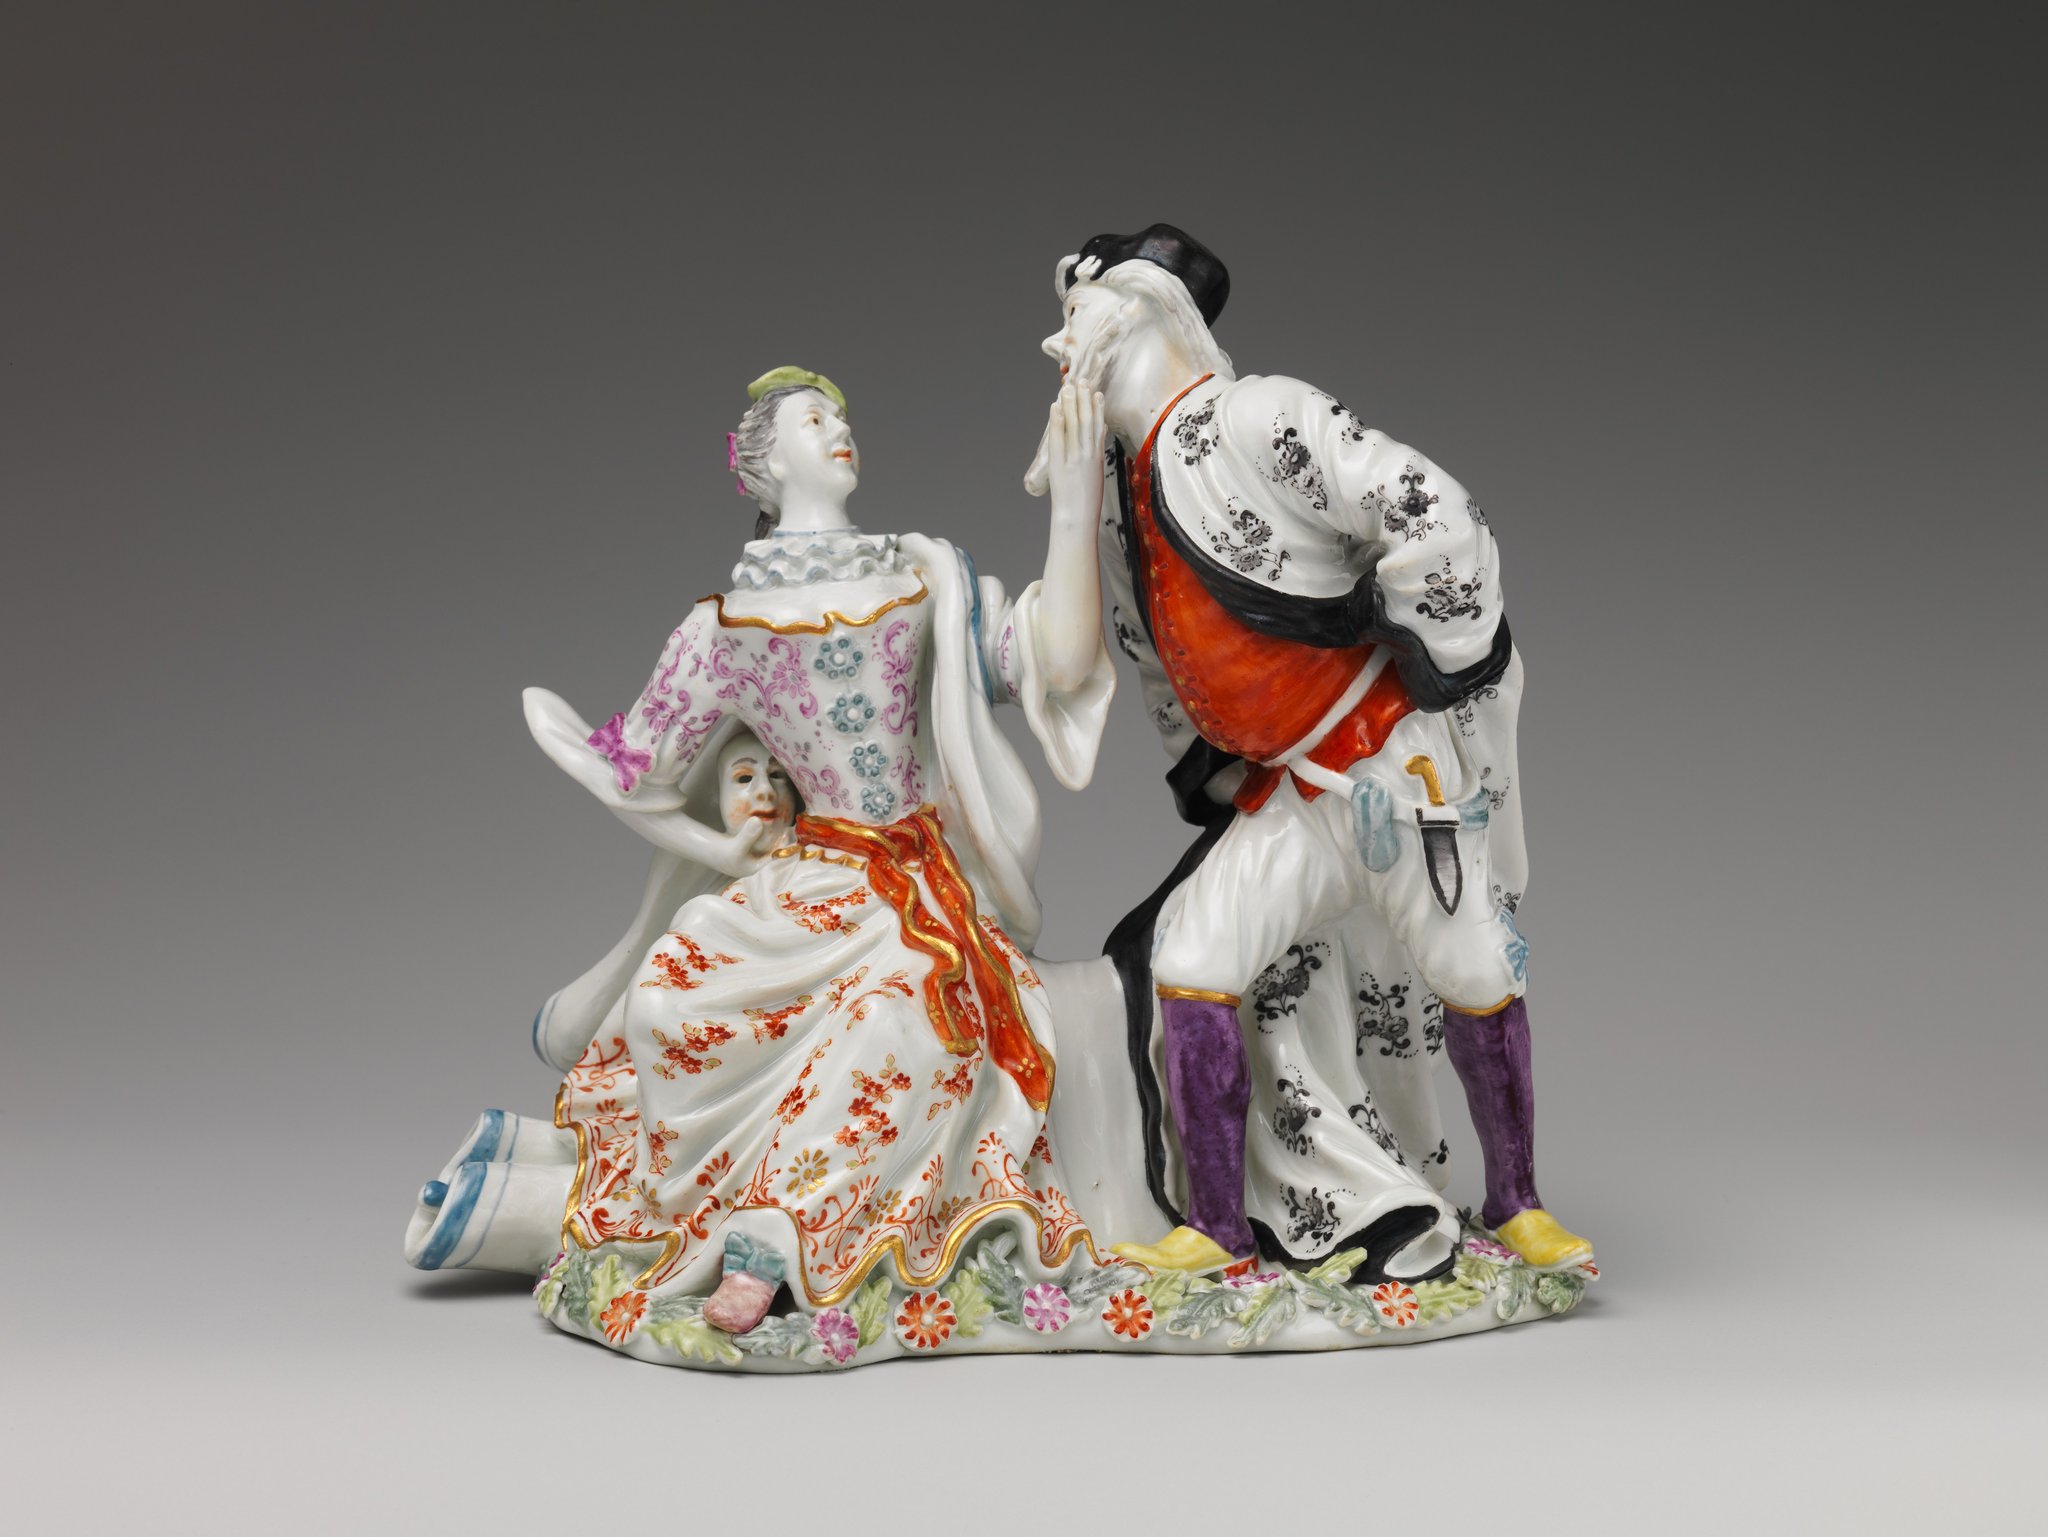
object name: group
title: Columbine and Pantaloon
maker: vienna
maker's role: manufactory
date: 1741-1744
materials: hard paste porcelain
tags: men,women